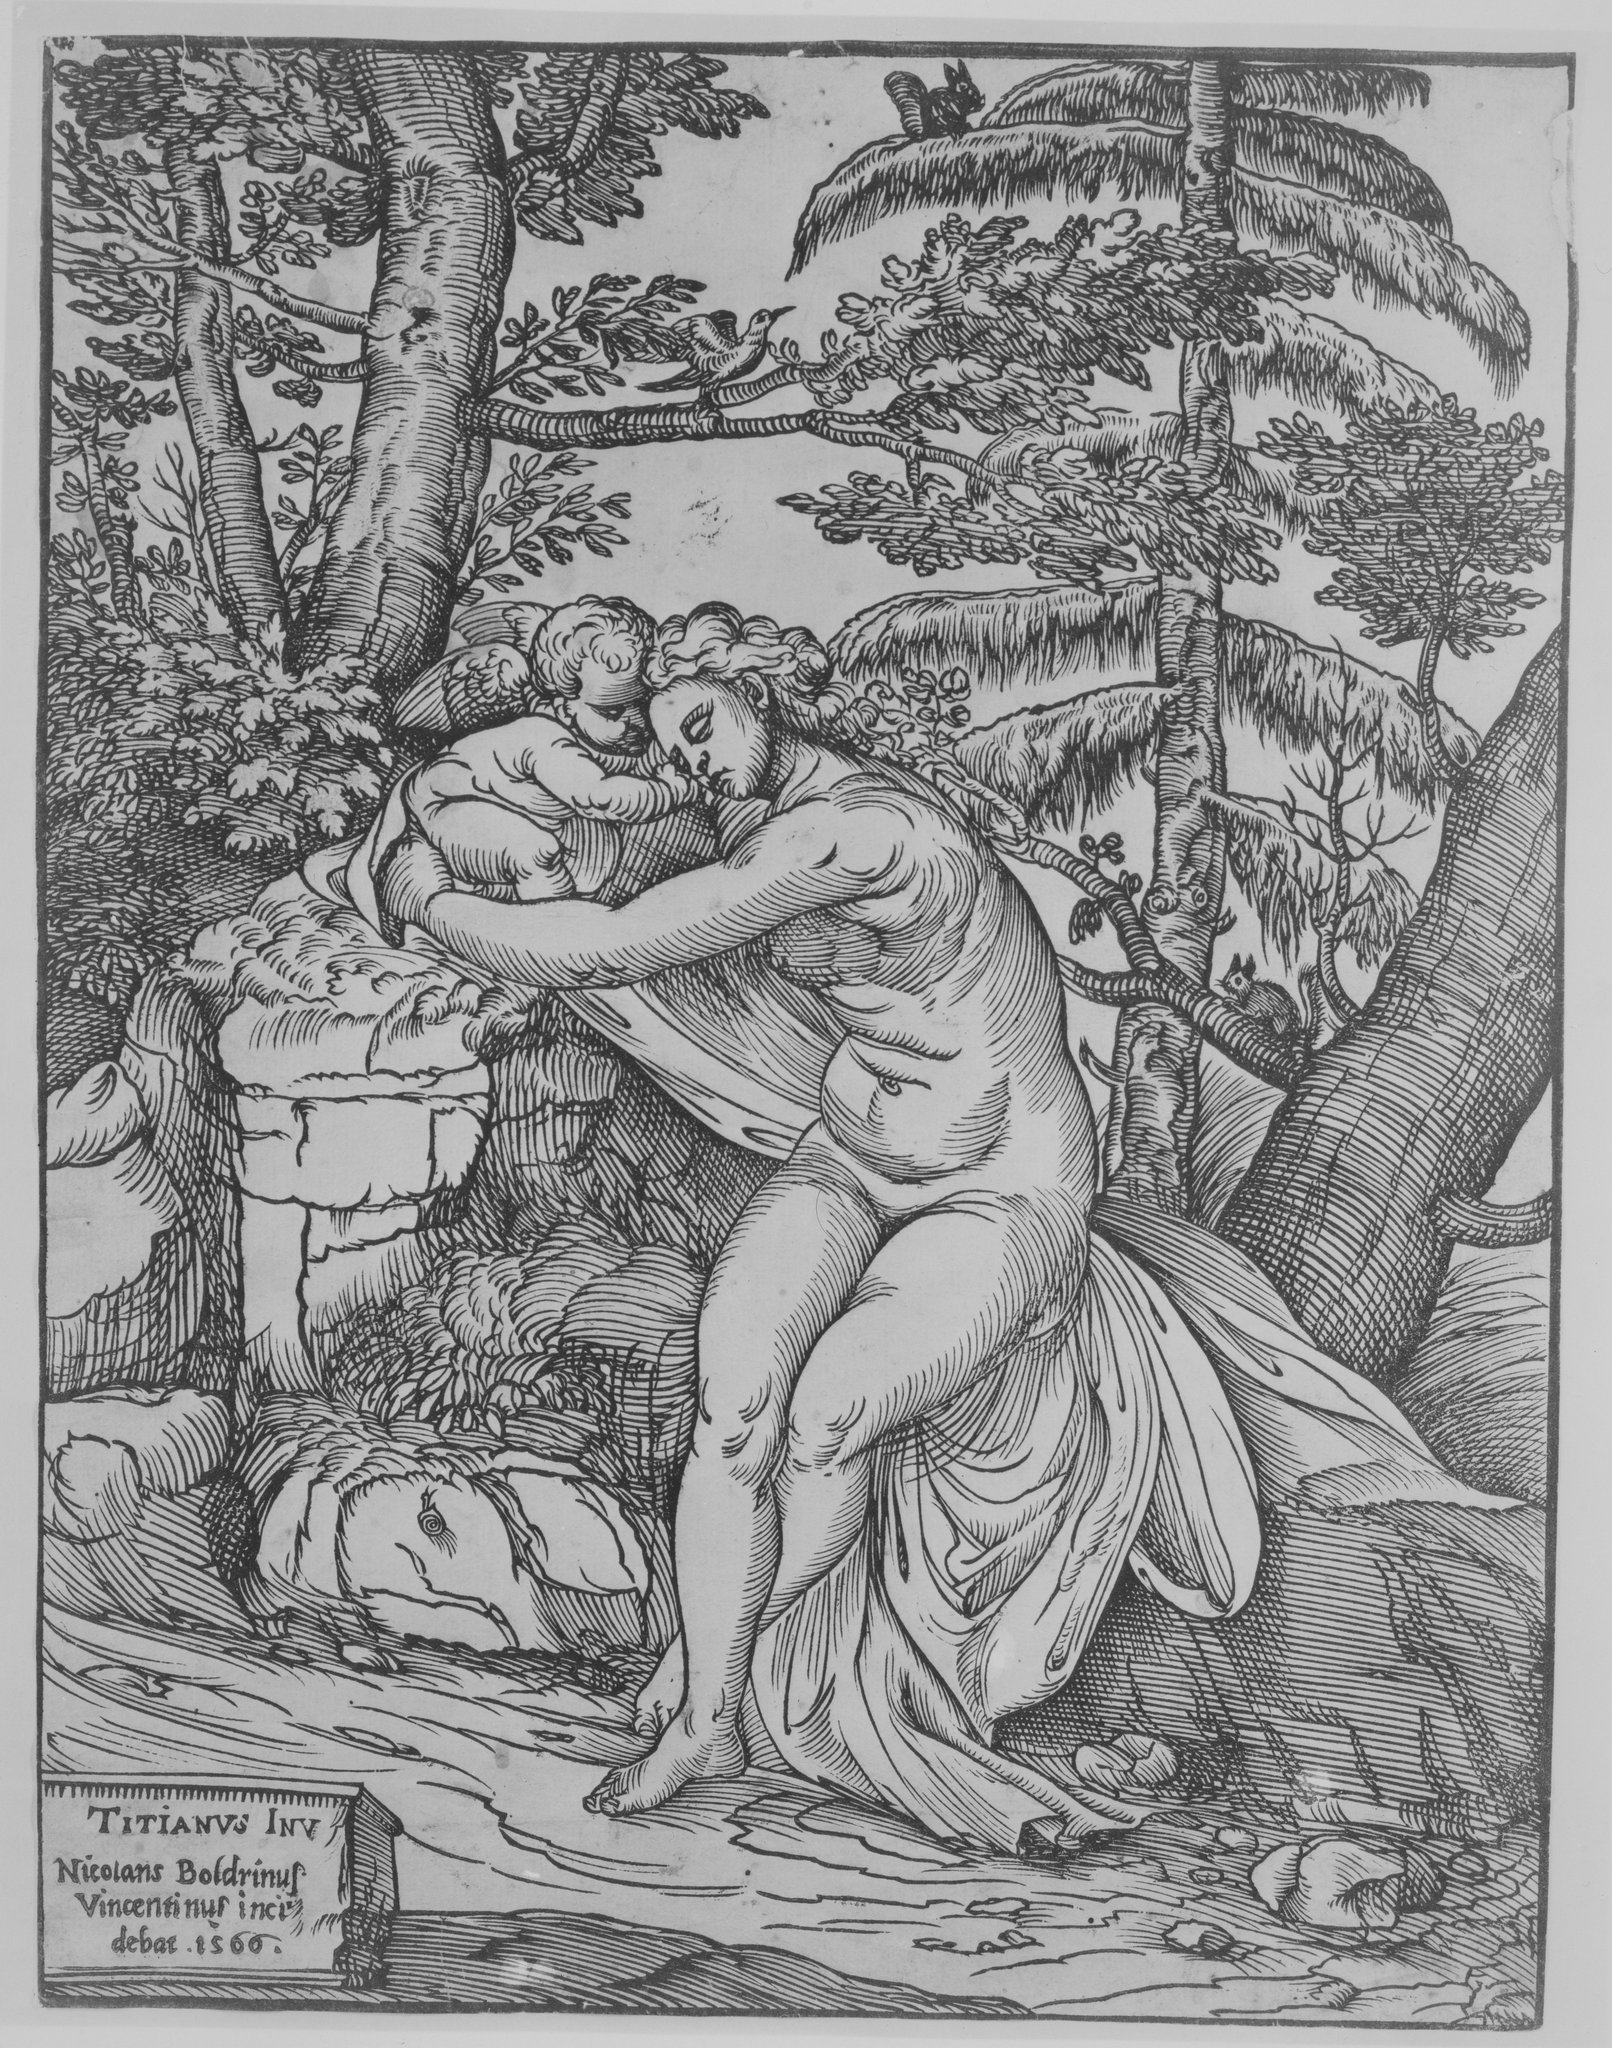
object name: print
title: Venus and Cupid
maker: nicolò boldrini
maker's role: artist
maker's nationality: italian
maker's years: 1500-1566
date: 1566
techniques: woodcut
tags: cupid,venus